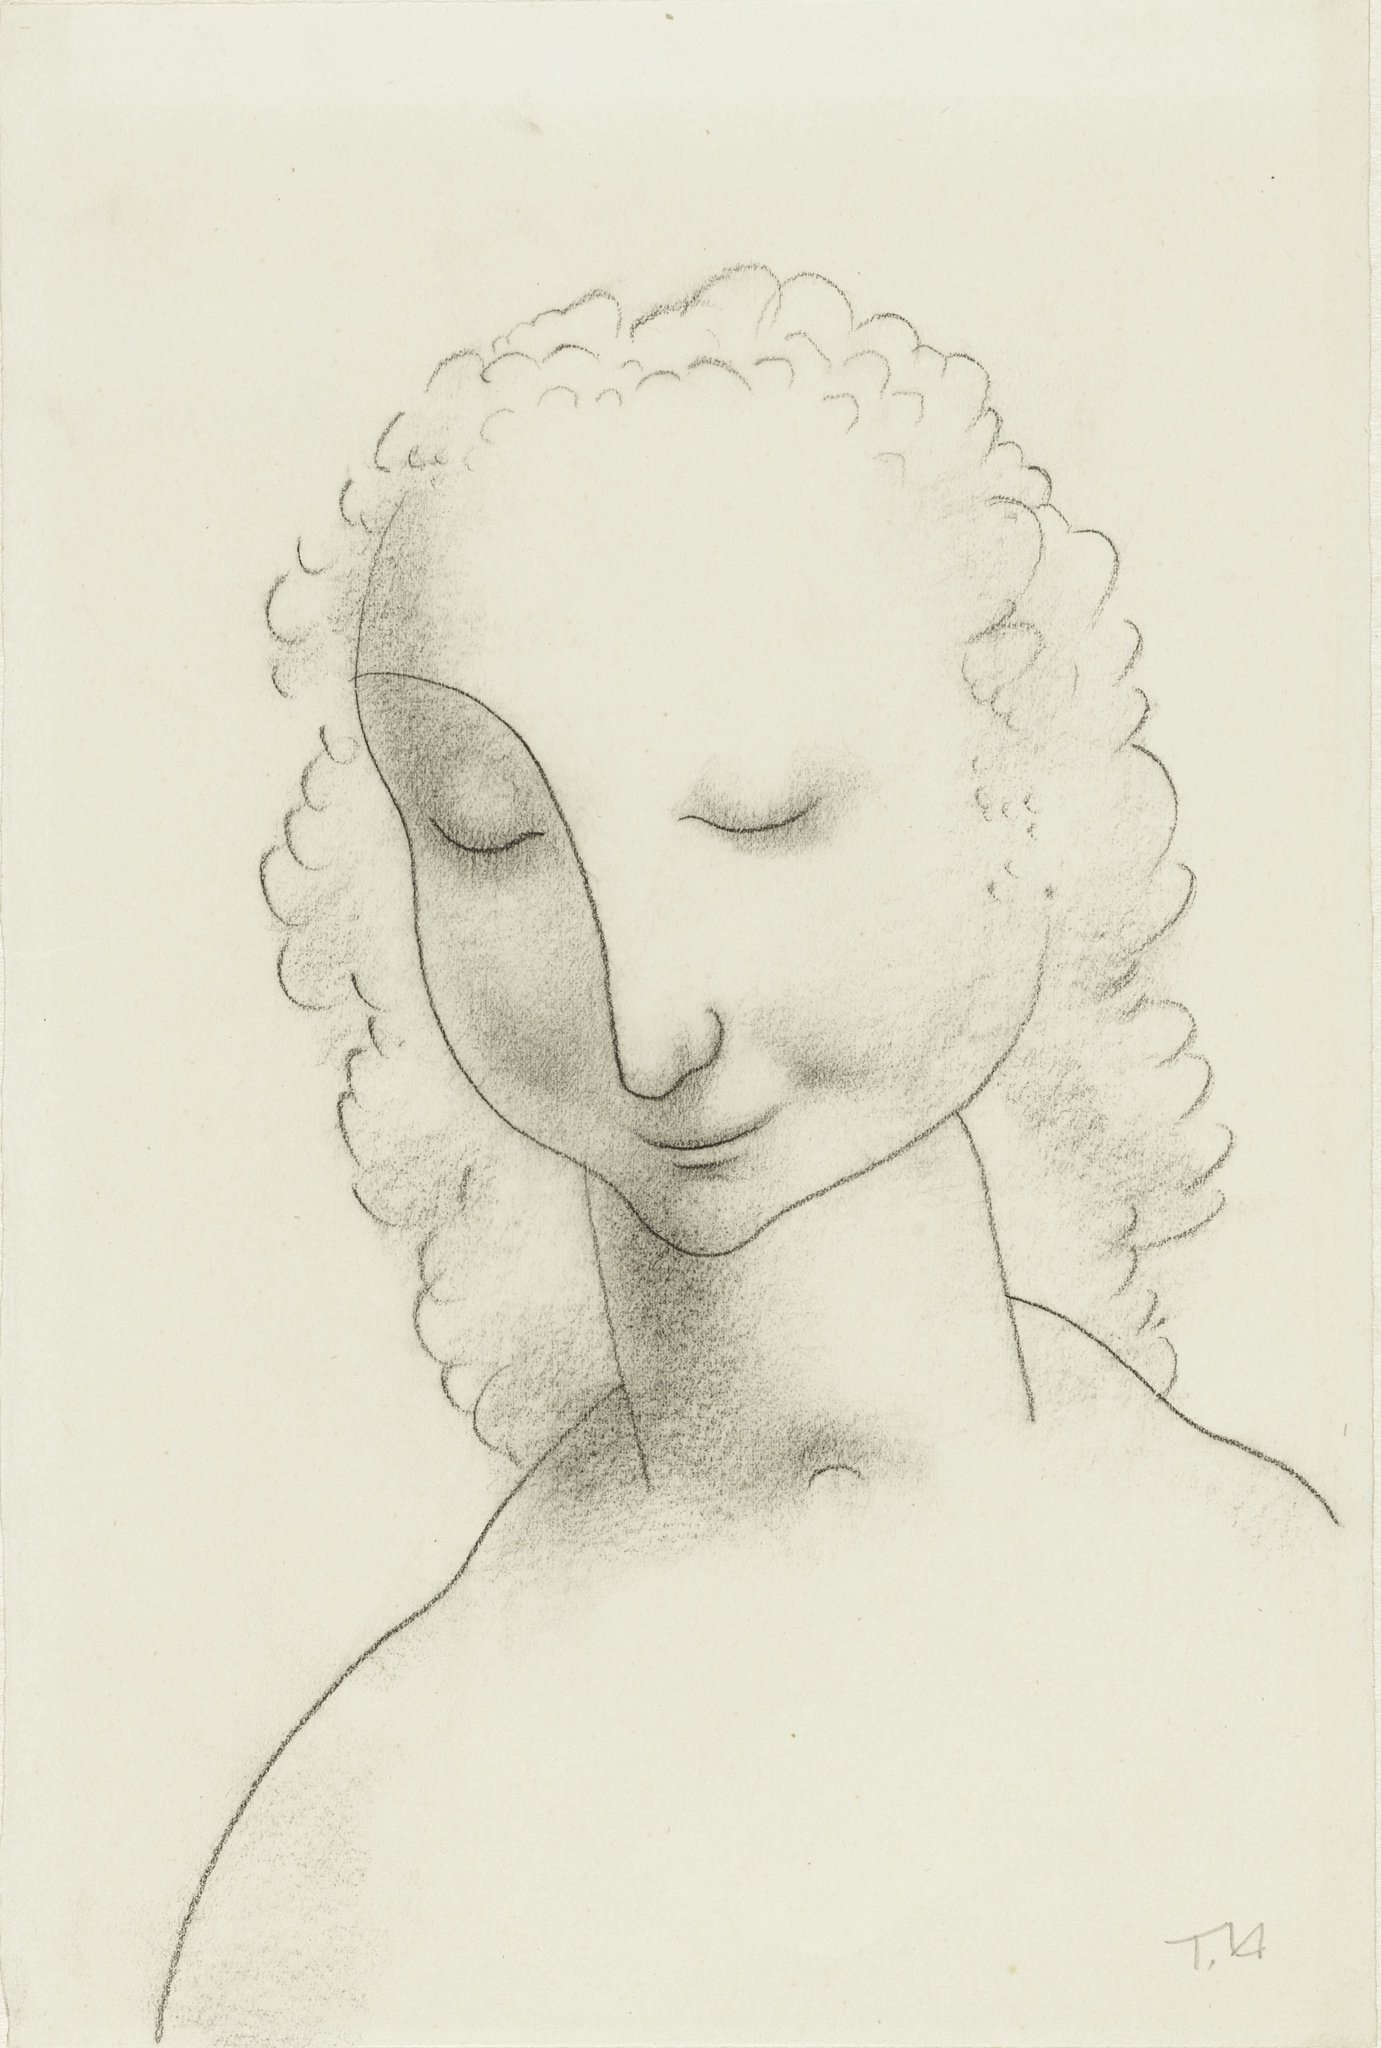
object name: drawing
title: Hoofd van een vrouw met gesloten ogen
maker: tinus van doorn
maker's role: painter, print maker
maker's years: 1905-1940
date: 1915-1940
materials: paper, pencil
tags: head in normal upright position, eyes closed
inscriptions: stamp: ‘Rotterdam’, inscription: ‘16’, collector's mark: Lugt 2228